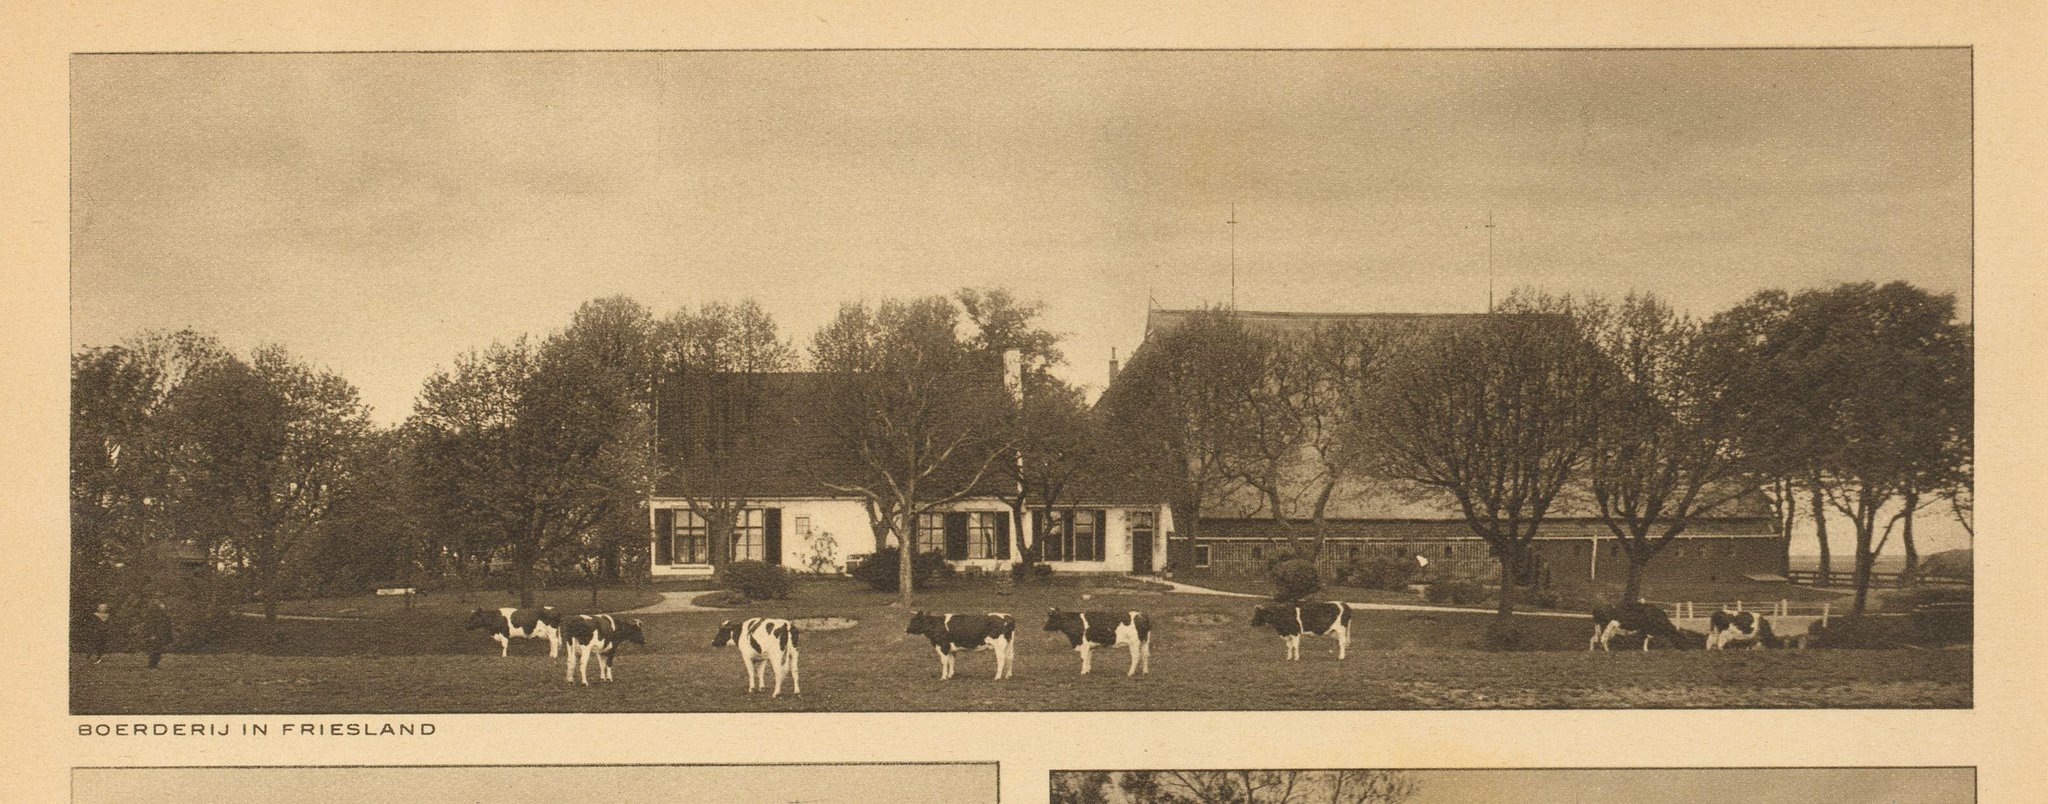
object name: album leaf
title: Gezicht op een boerderij in Friesland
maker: Anonymous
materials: paper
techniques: rotogravure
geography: leiden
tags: cow, farm (building)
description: Deze prent maakt deel uit van een album.